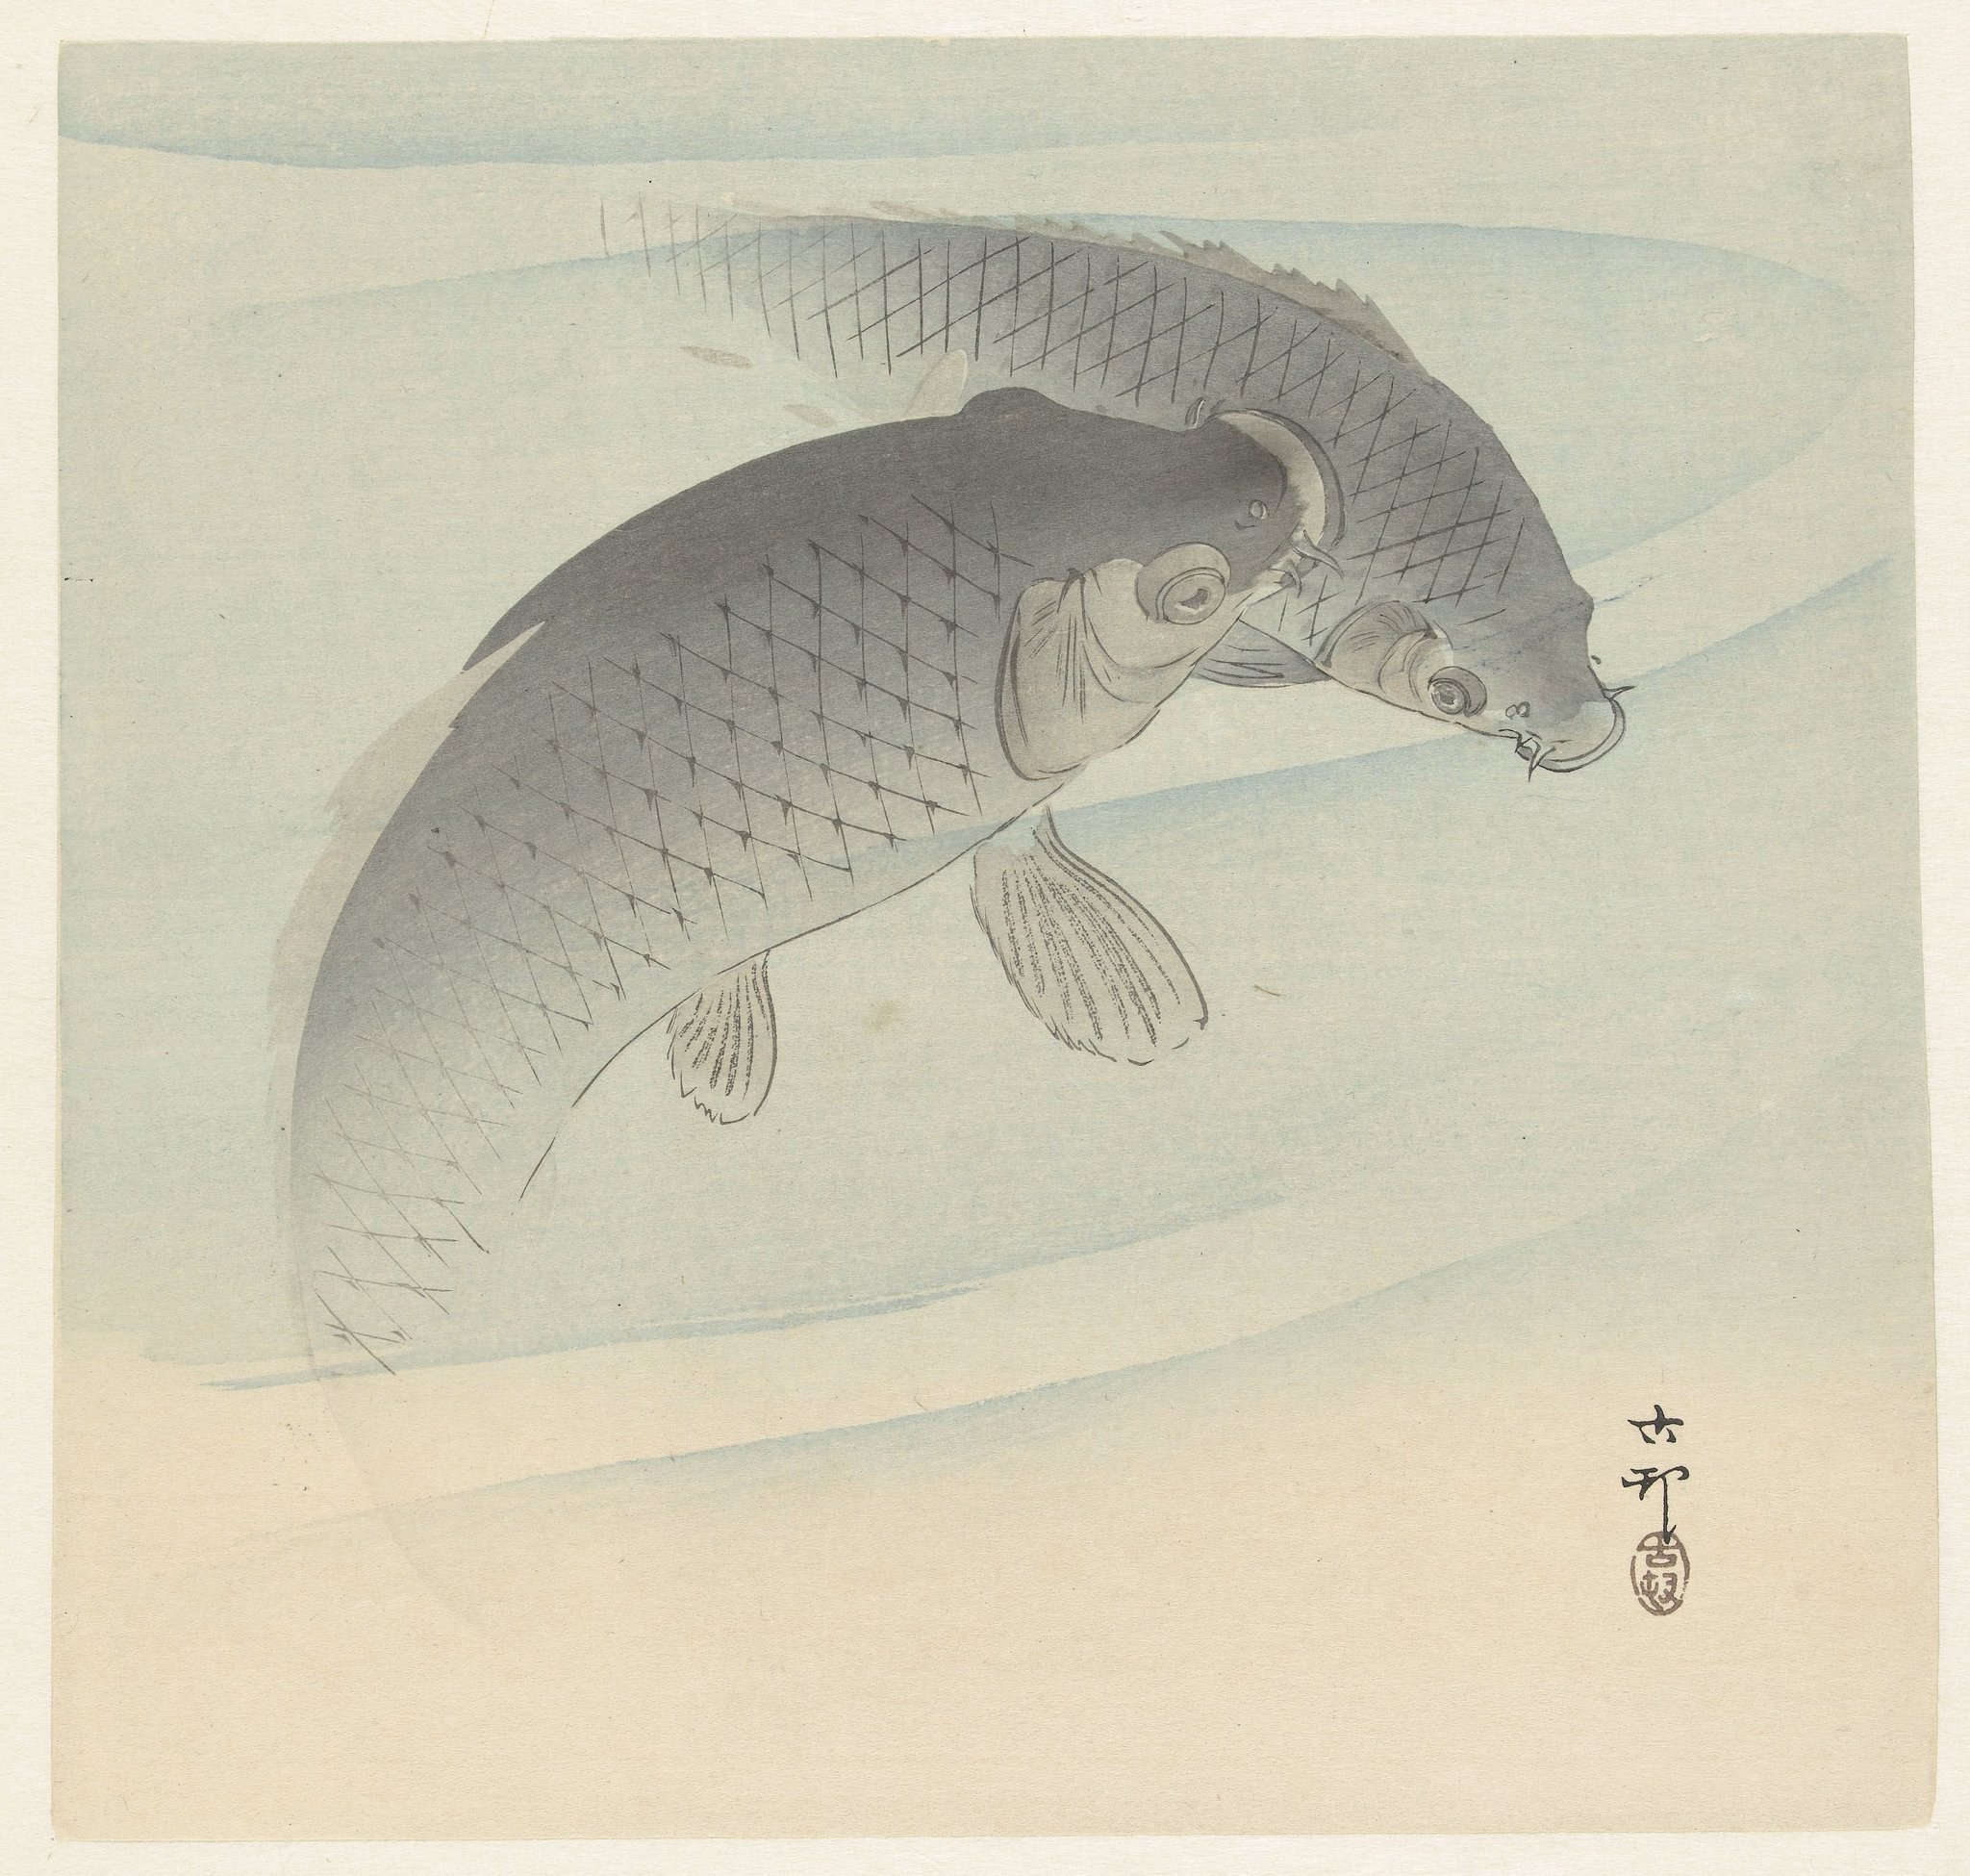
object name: print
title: Twee karpers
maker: ohara koson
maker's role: print maker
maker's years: 1877-1945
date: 1900-1910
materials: paper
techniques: woodcut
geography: japan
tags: bony fishes: carp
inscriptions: collector's mark: Lugt 2228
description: Twee grijsblauwe karpers zwemmend in helder blauw water.